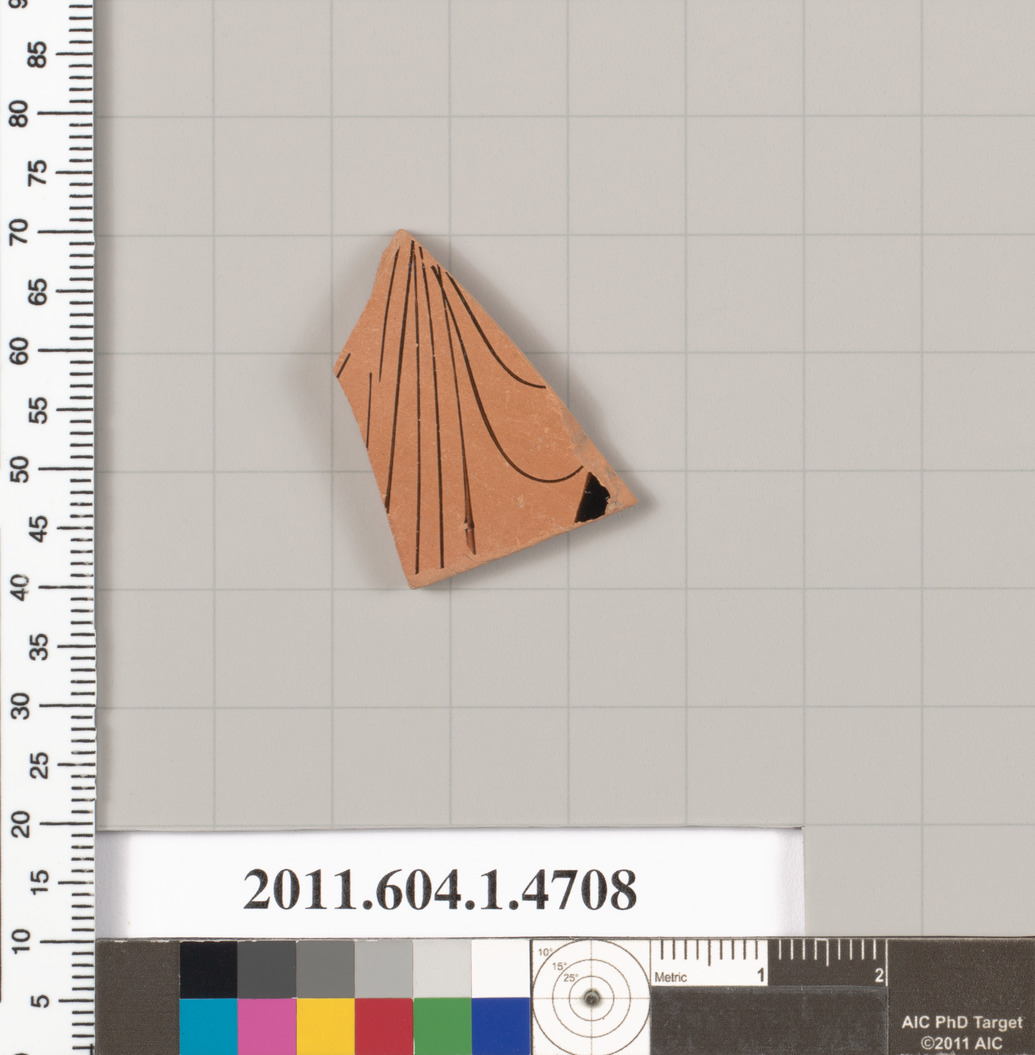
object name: kylix fragment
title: Terracotta fragment of a kylix (drinking cup)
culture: greek, attic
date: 475-451 BCE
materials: terracotta